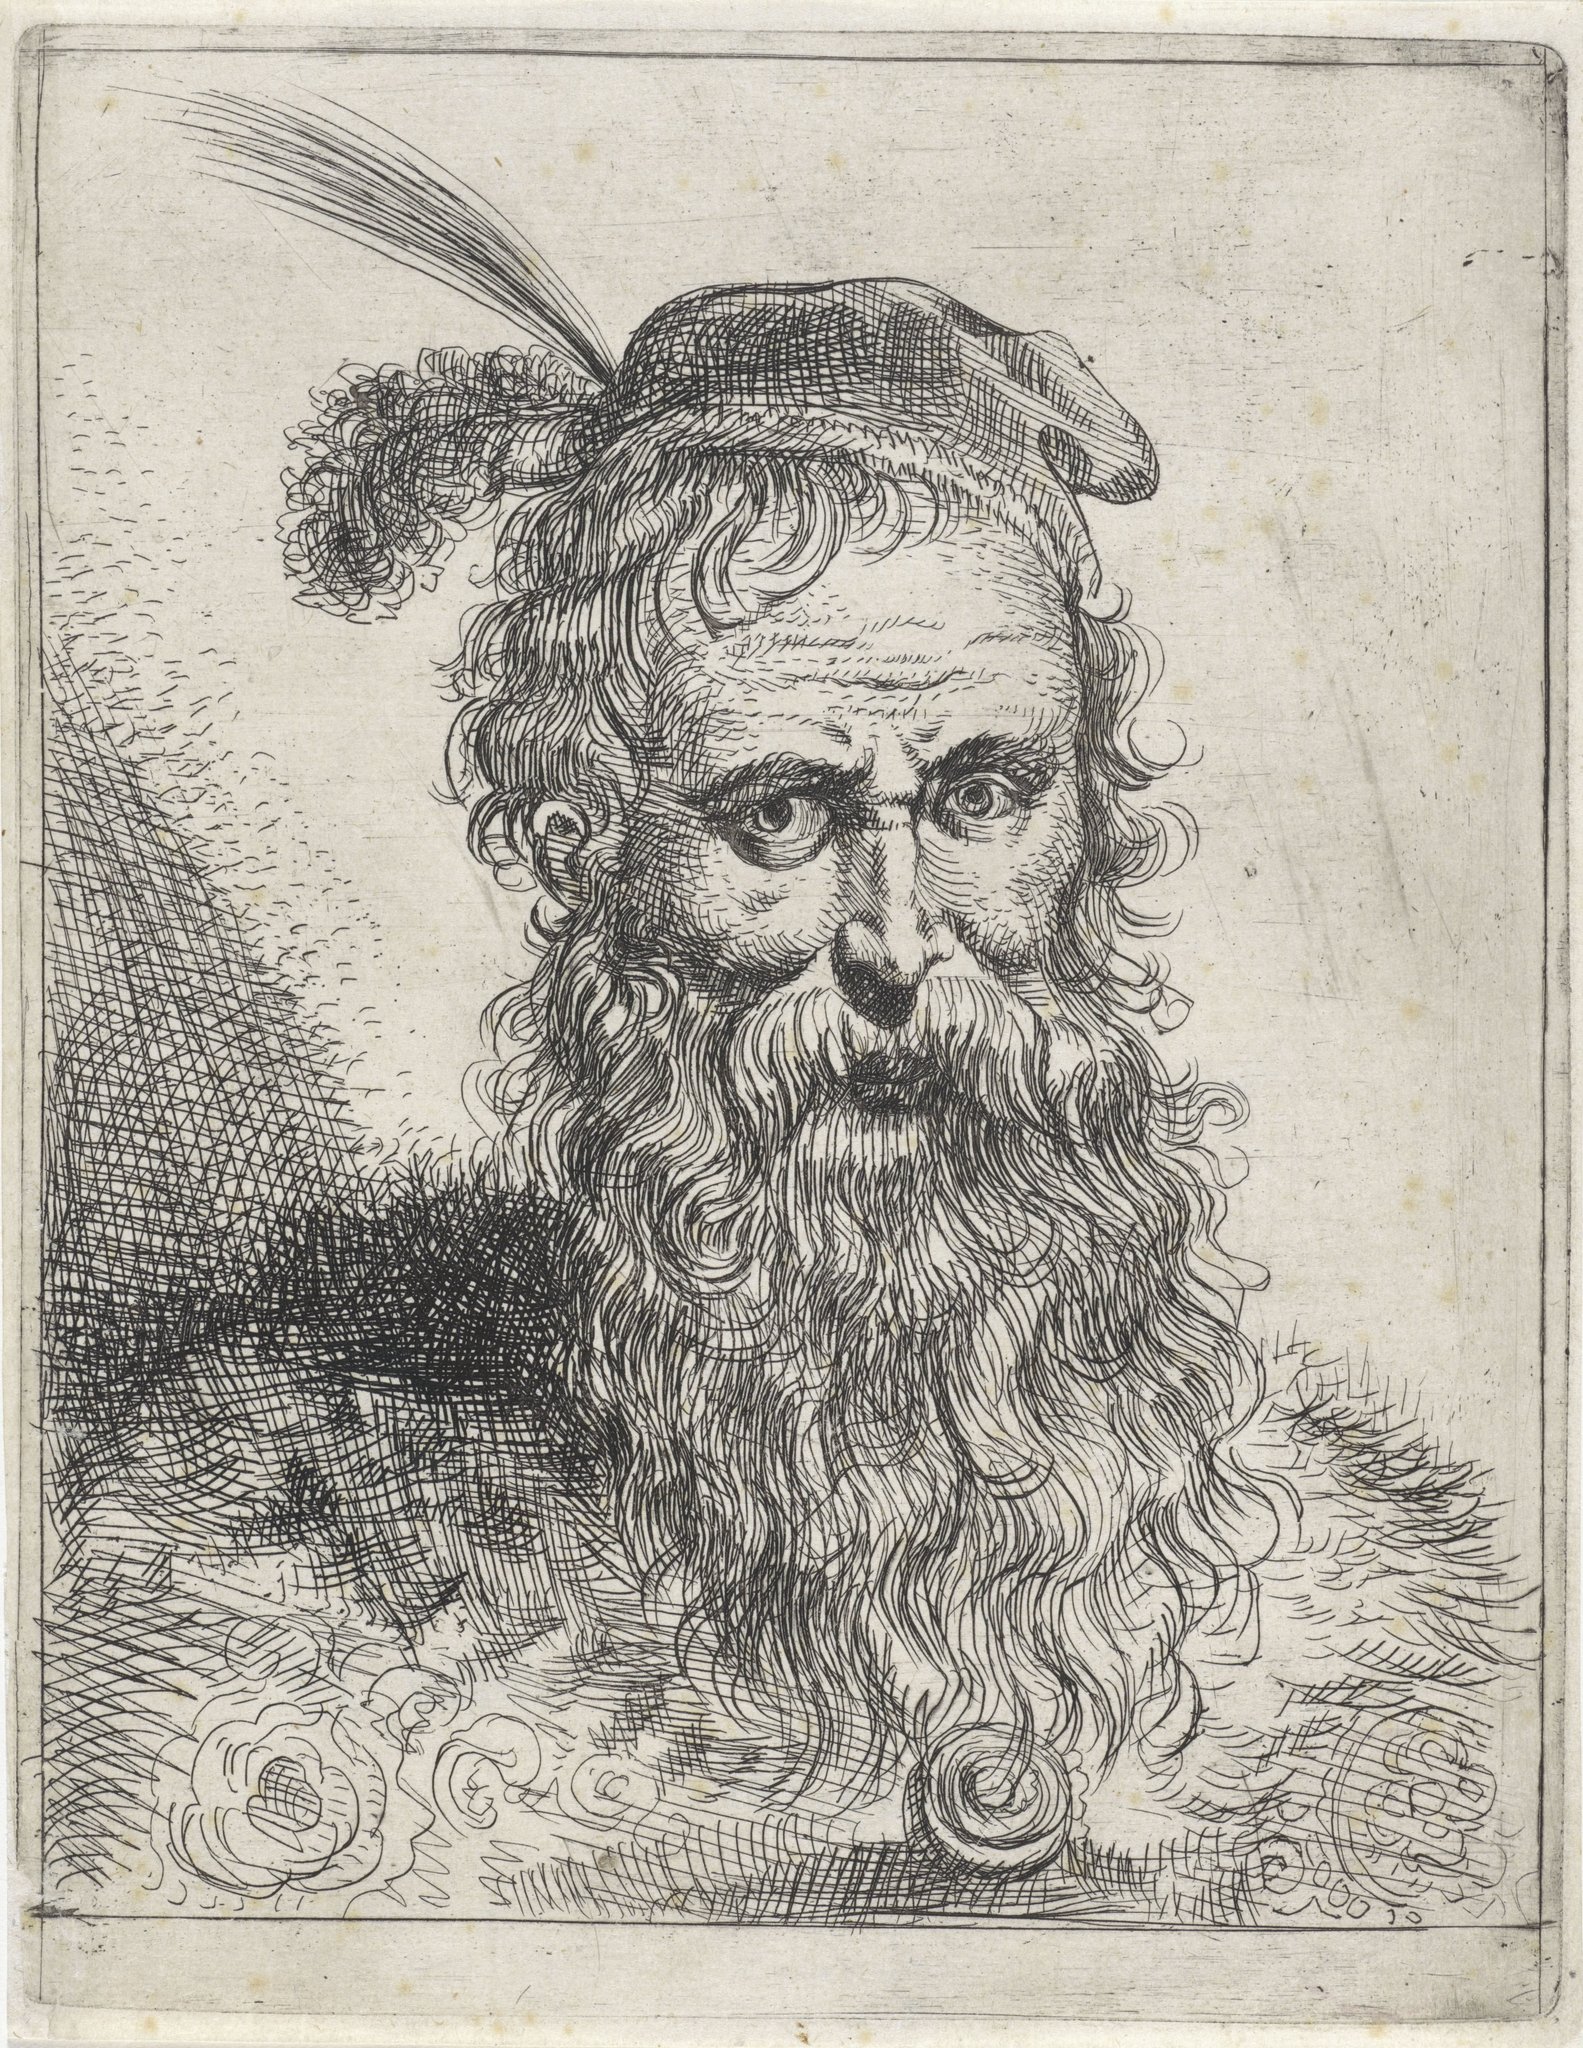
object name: print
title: Portret van Godfried Chodkiewicz, hertog van Moskou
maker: gerard seghers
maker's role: painter, print maker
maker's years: 1591-1651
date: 1591-1651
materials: paper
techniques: etching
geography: antwerp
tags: hertog, godfried chodkiewicz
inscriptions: collector's mark: Lugt 240